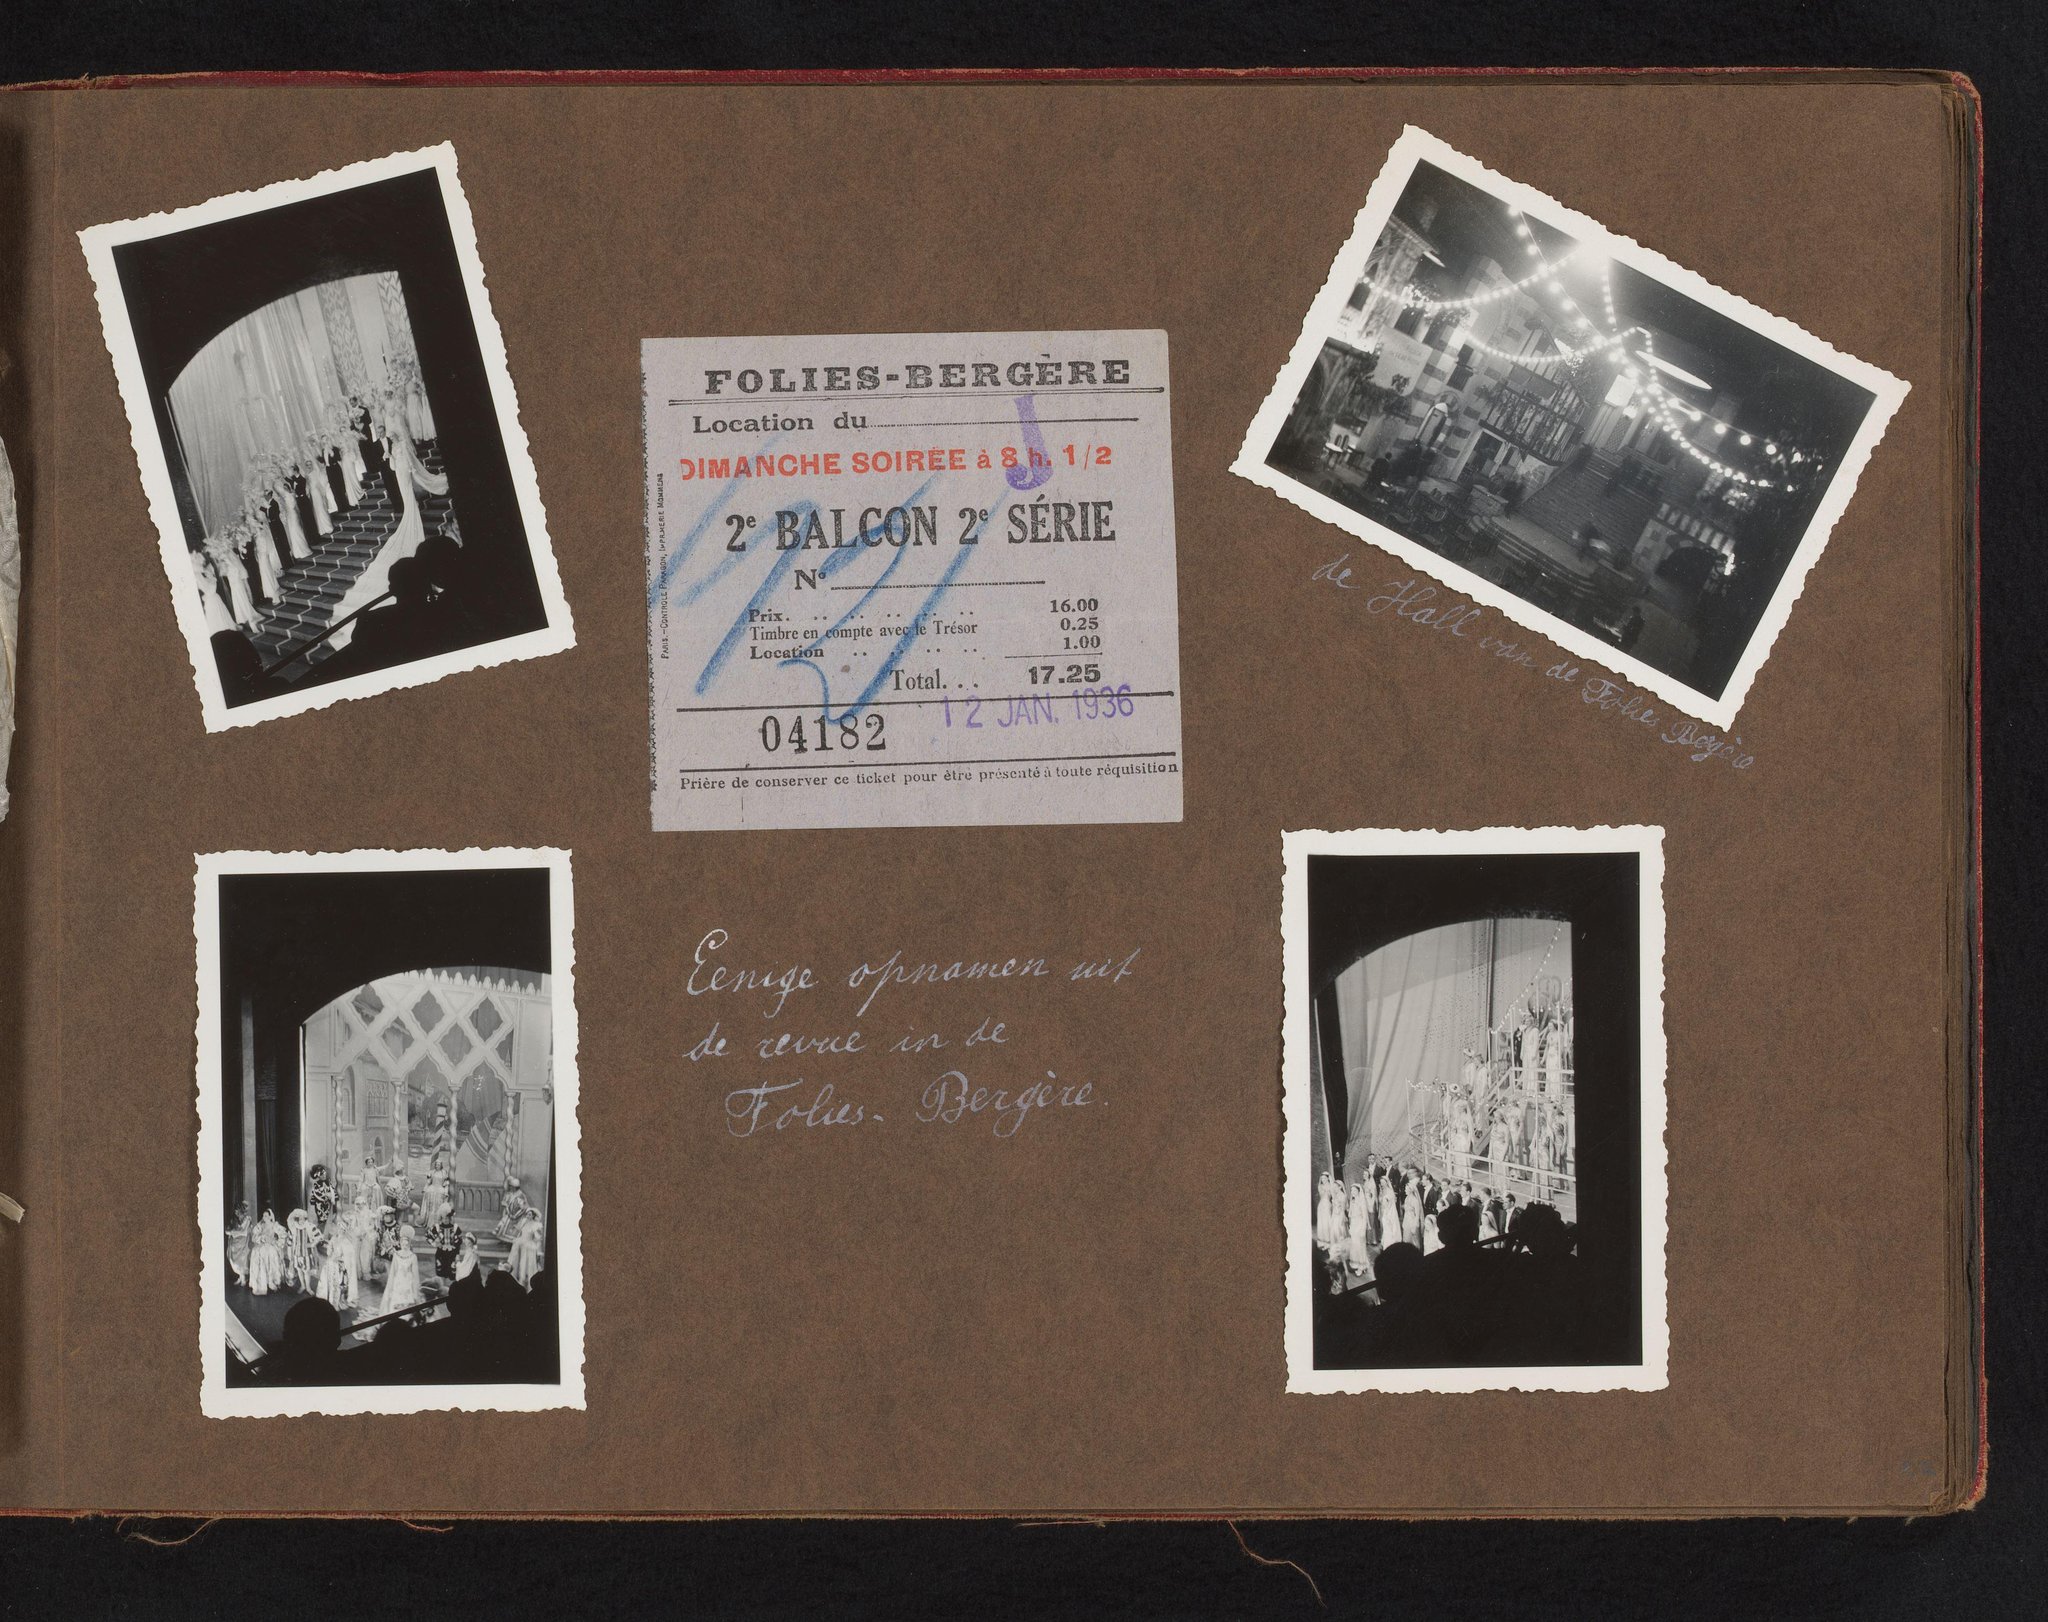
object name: album leaf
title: Bezoek aan de Folies Bergère te Parijs, 1936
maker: Anonymous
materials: paper, photographic support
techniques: gelatin silver print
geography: paris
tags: soccer, football (early names: soule, choule, cholle), outing, pleasure trip, vaudeville, variety-show, hotel, hostelry, inn, paris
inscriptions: inscription: ‘Eenige opnamen uit de revue in de Folies-Bergère’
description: Albumblad met een toegangskaartje en vier foto's van een bezoek aan de Folies Bergère te Parijs, 12 januari 1936. Op 11 januari 1936 vertrekt de samensteller van het fotoalbum naar Parijs om daar op 12 januari een voetbalwedstrijd tussen Frankrijk en Nederland bij te wonen (Nederland wint met 6-1). Onderdeel van het reisalbum van de familie Van den Broek 1935-1937.